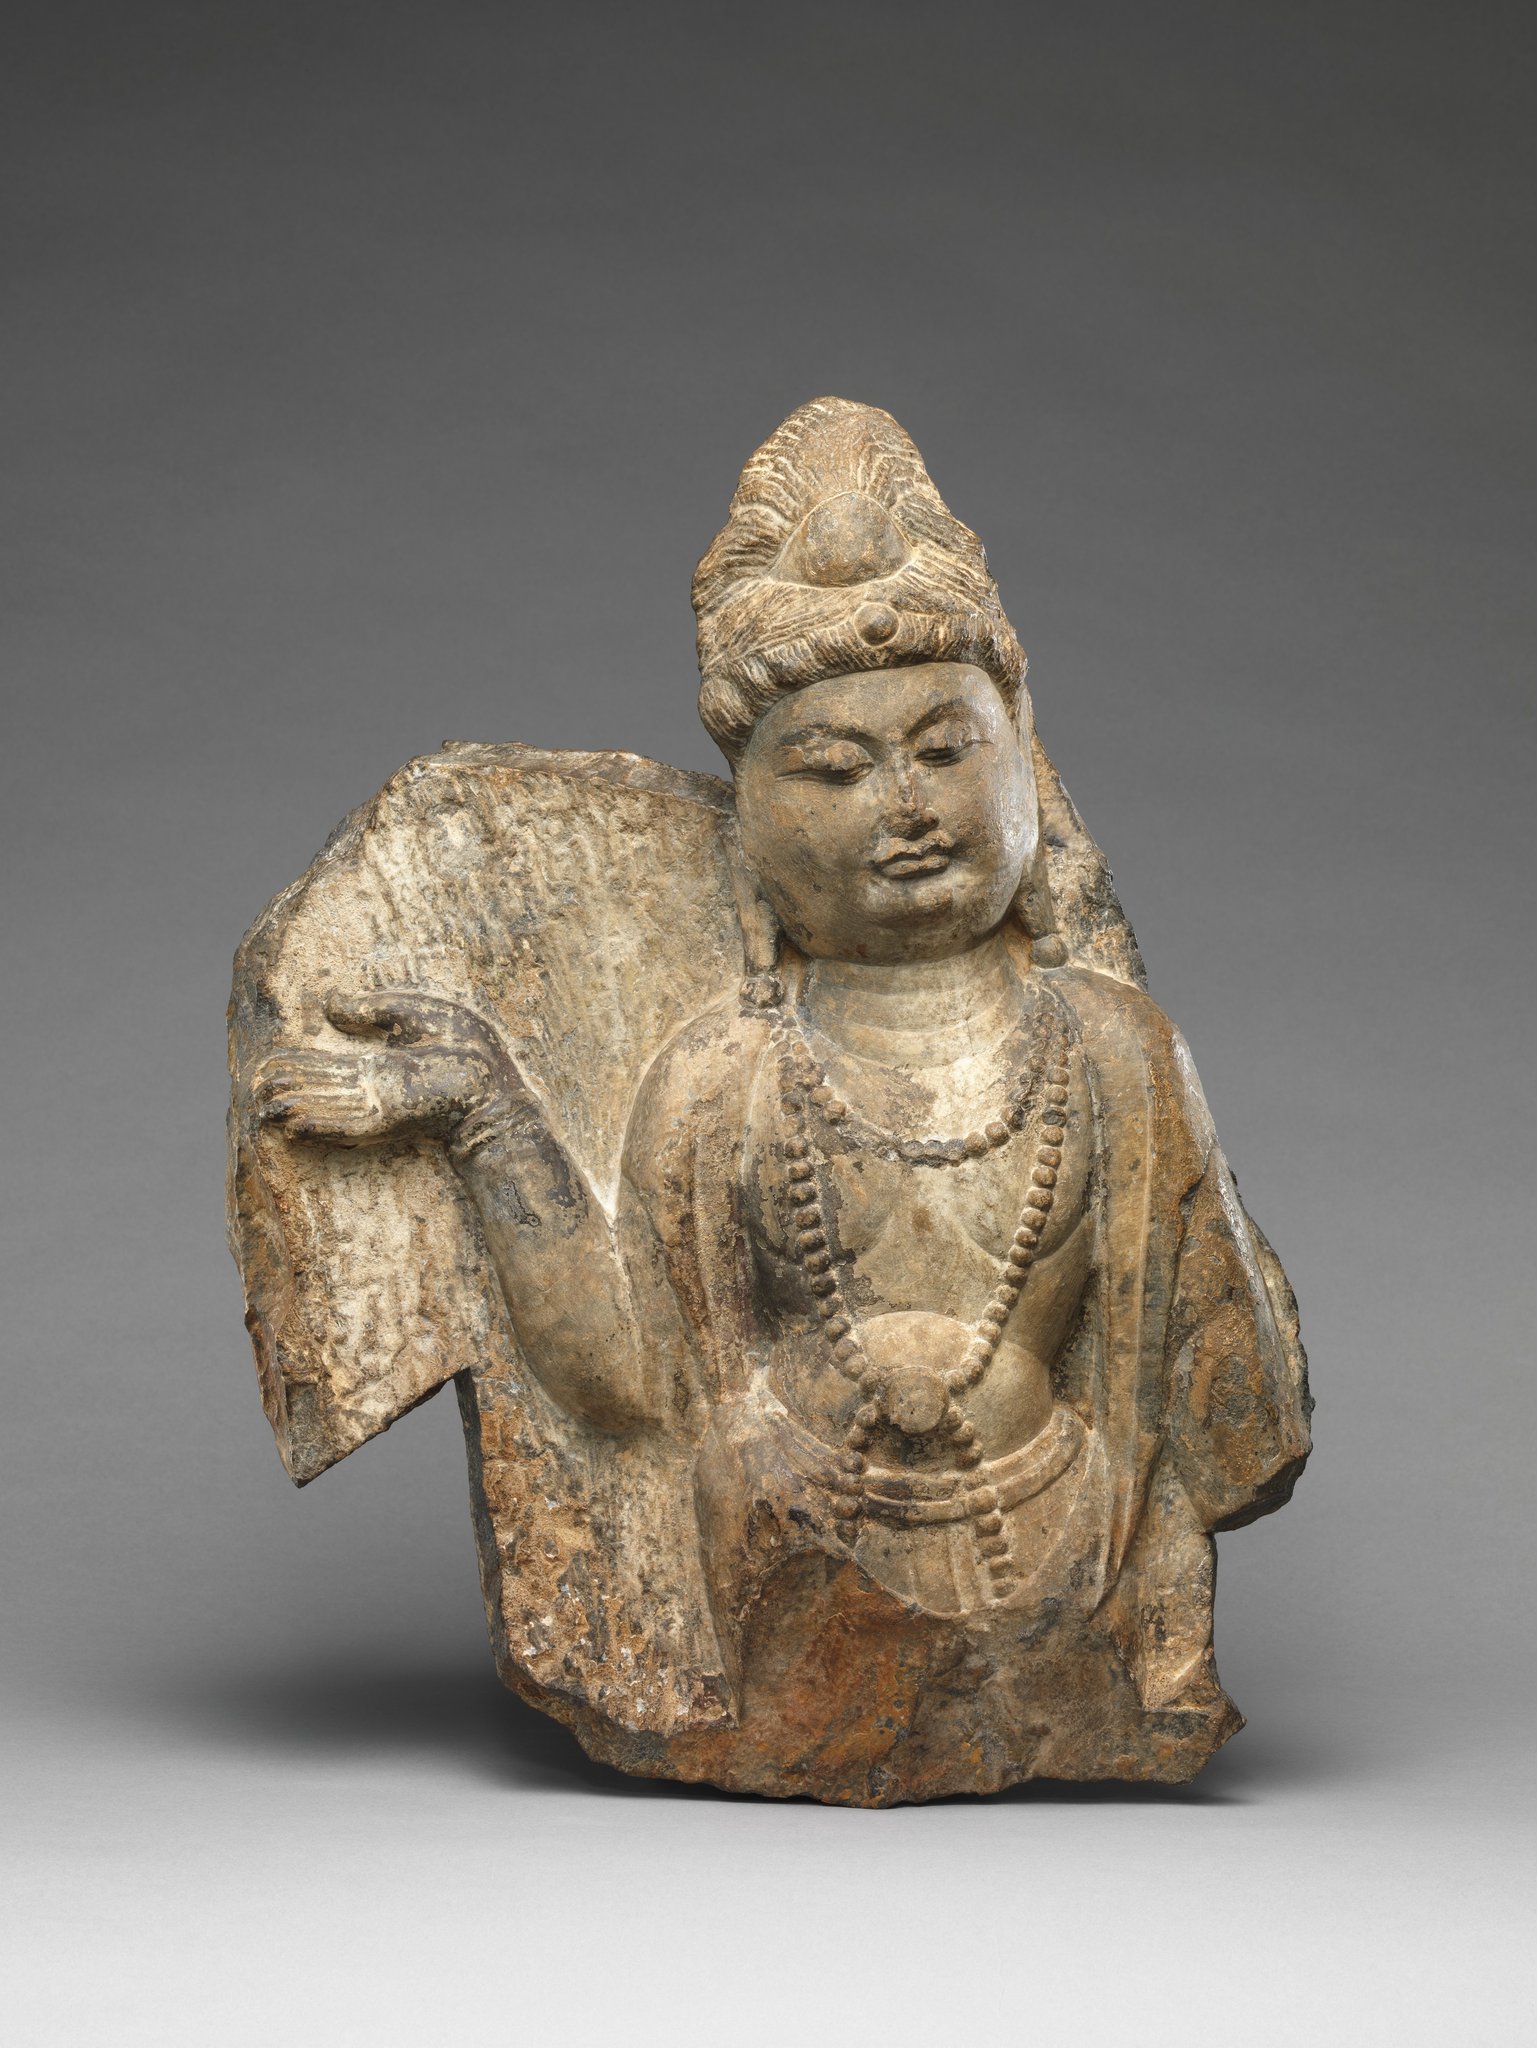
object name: part of figure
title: Bodhisattva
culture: chinese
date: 701-900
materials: limestone, pigment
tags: bodhisattvas